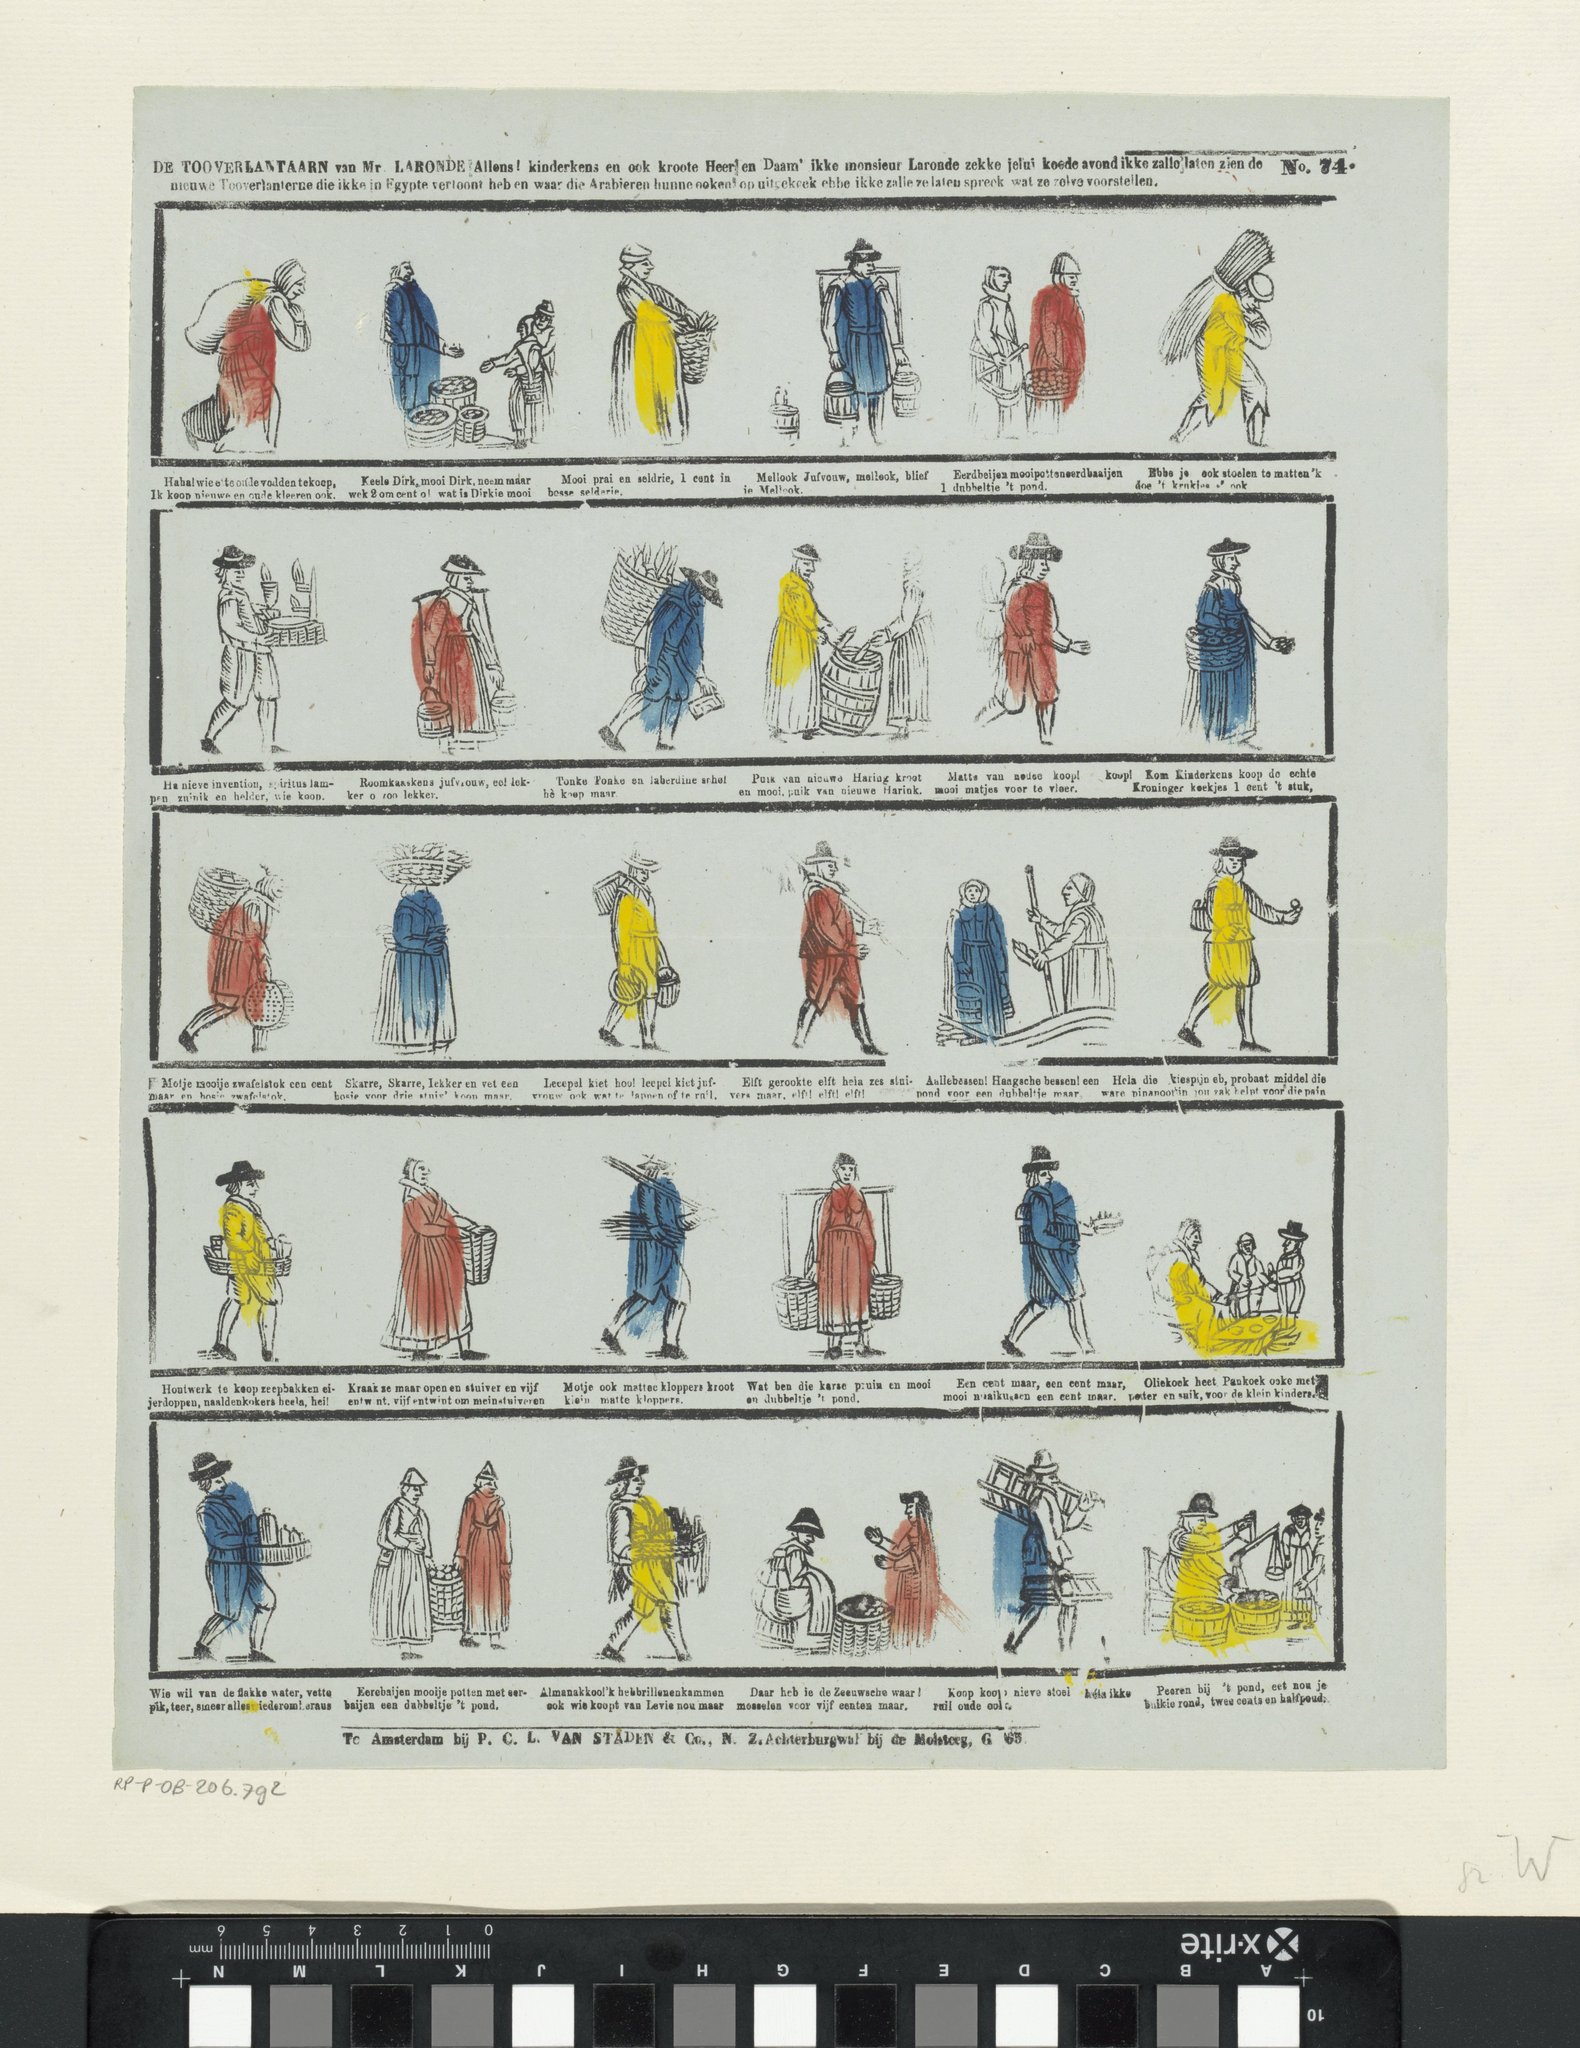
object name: print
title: De tooverlantaarn van mr. Laronde [(...)]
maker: Anonymous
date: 1850-1870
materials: paper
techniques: colour, letterpress printing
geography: netherlands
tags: street-trader, merchant, salesman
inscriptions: collector's mark: Lugt 2760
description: Blad met 5 rijen met voorstellingen van verschillende straatventers: verkopers van o.a. vodden, huishoudelijke artikelen, groente en fruit, vis, almanakken, brillen en kammen, lucifers, hout, vloermatten. Onder elke voorstelling een onderschrift. Genummerd rechtsboven: No. 74.